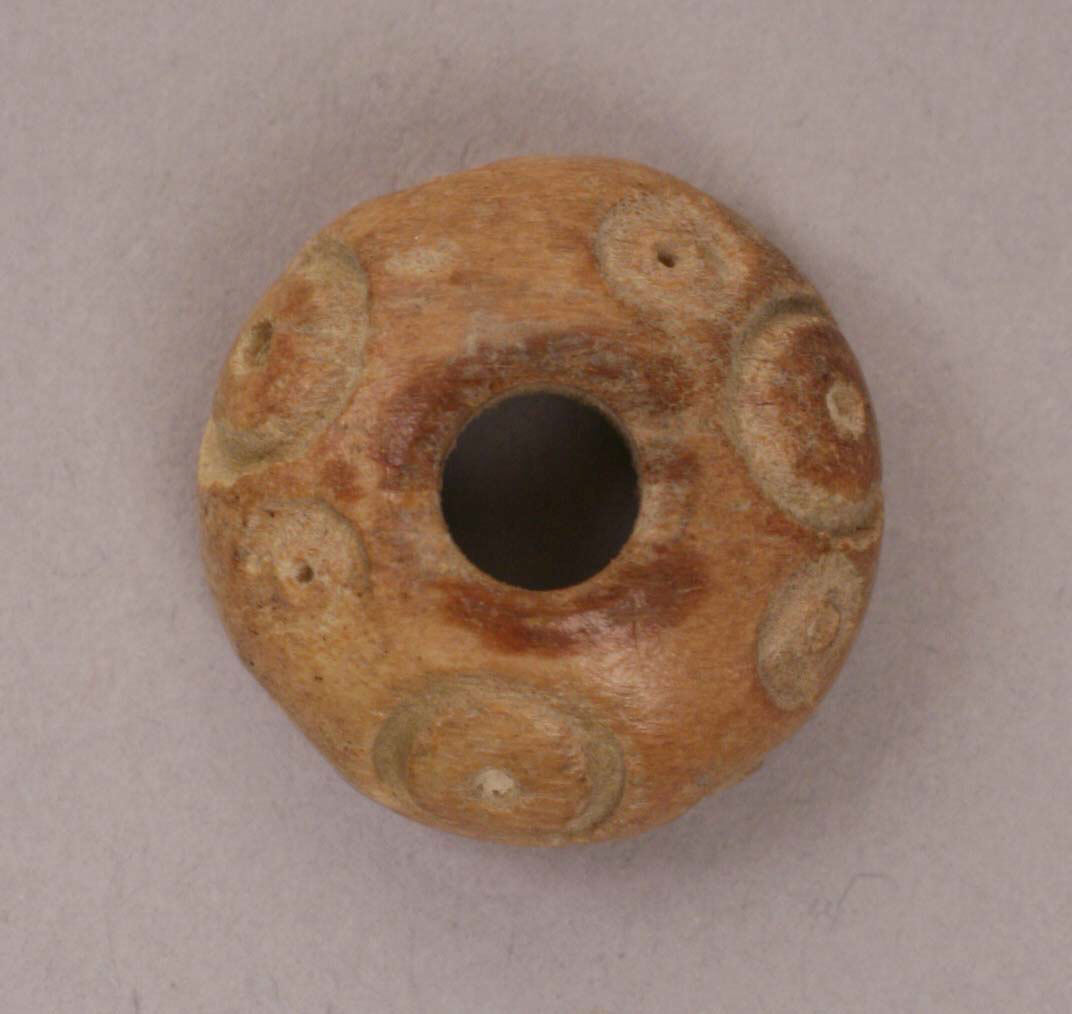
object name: button or bead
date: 801-1000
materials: bone, paint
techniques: incising, inlay, tinting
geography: iran